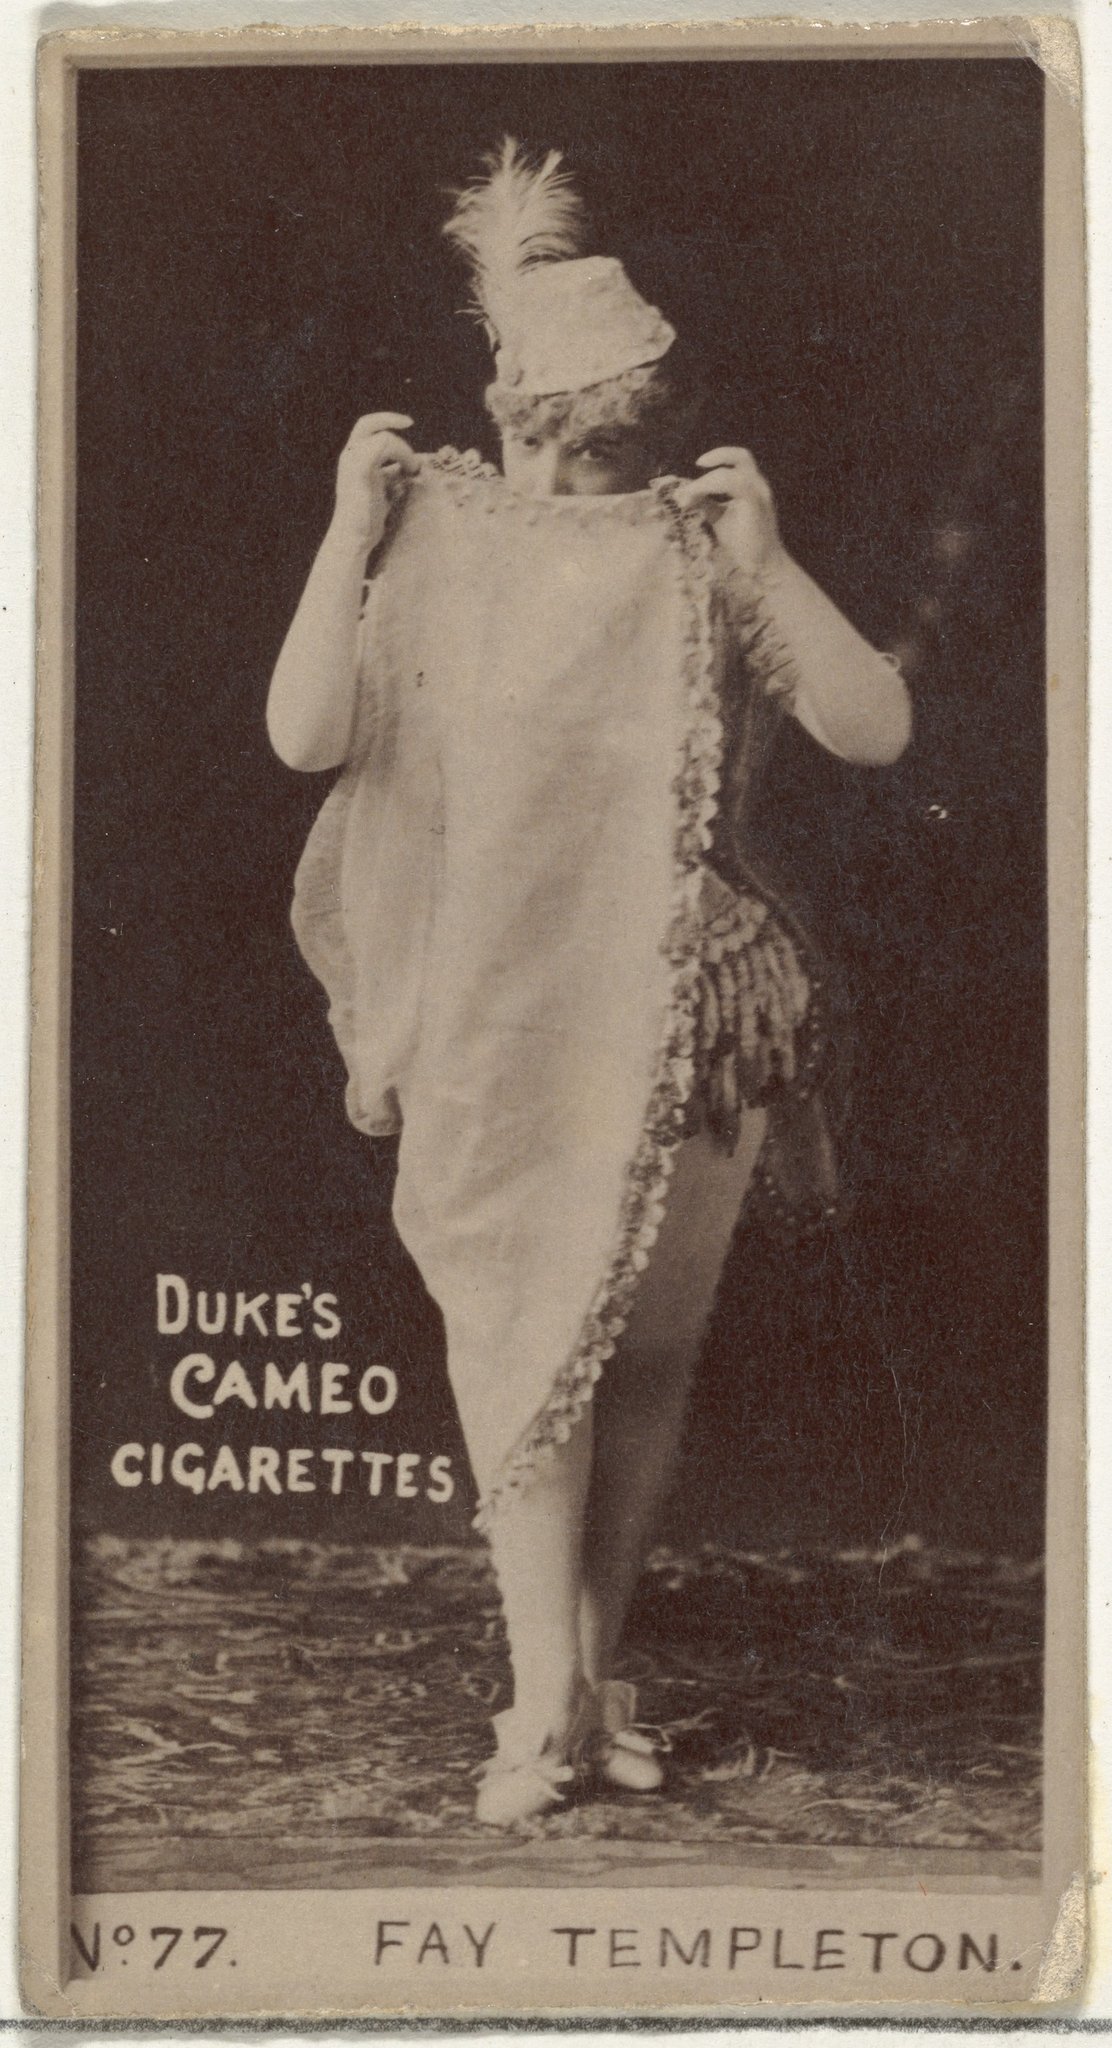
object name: photograph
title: Card Number 77, Fay Templeton, from the Actors and Actresses series (N145-4) issued by Duke Sons & Co. to promote Cameo Cigarettes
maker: w. duke, sons & co.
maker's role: publisher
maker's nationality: american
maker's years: 1870-1920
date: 1880-1889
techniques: albumen silver print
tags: portraits,women,actresses